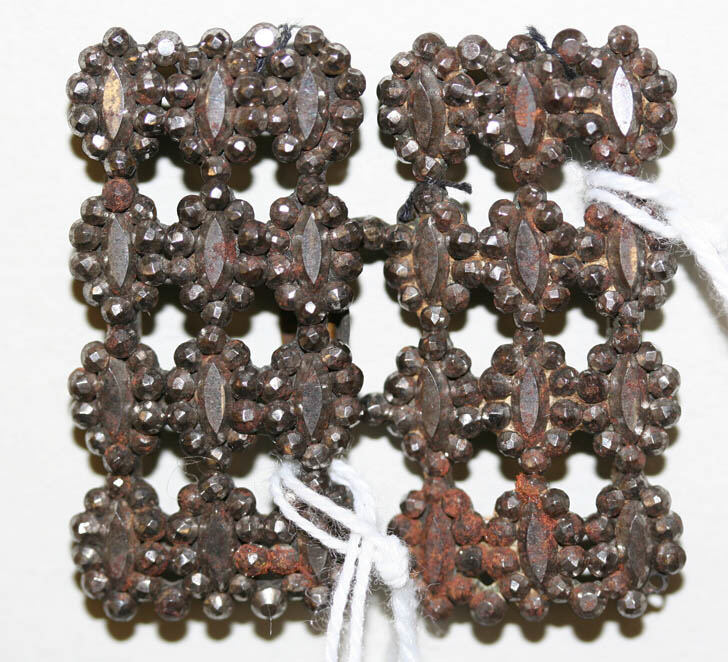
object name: belt buckle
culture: european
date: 1830-1839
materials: steel